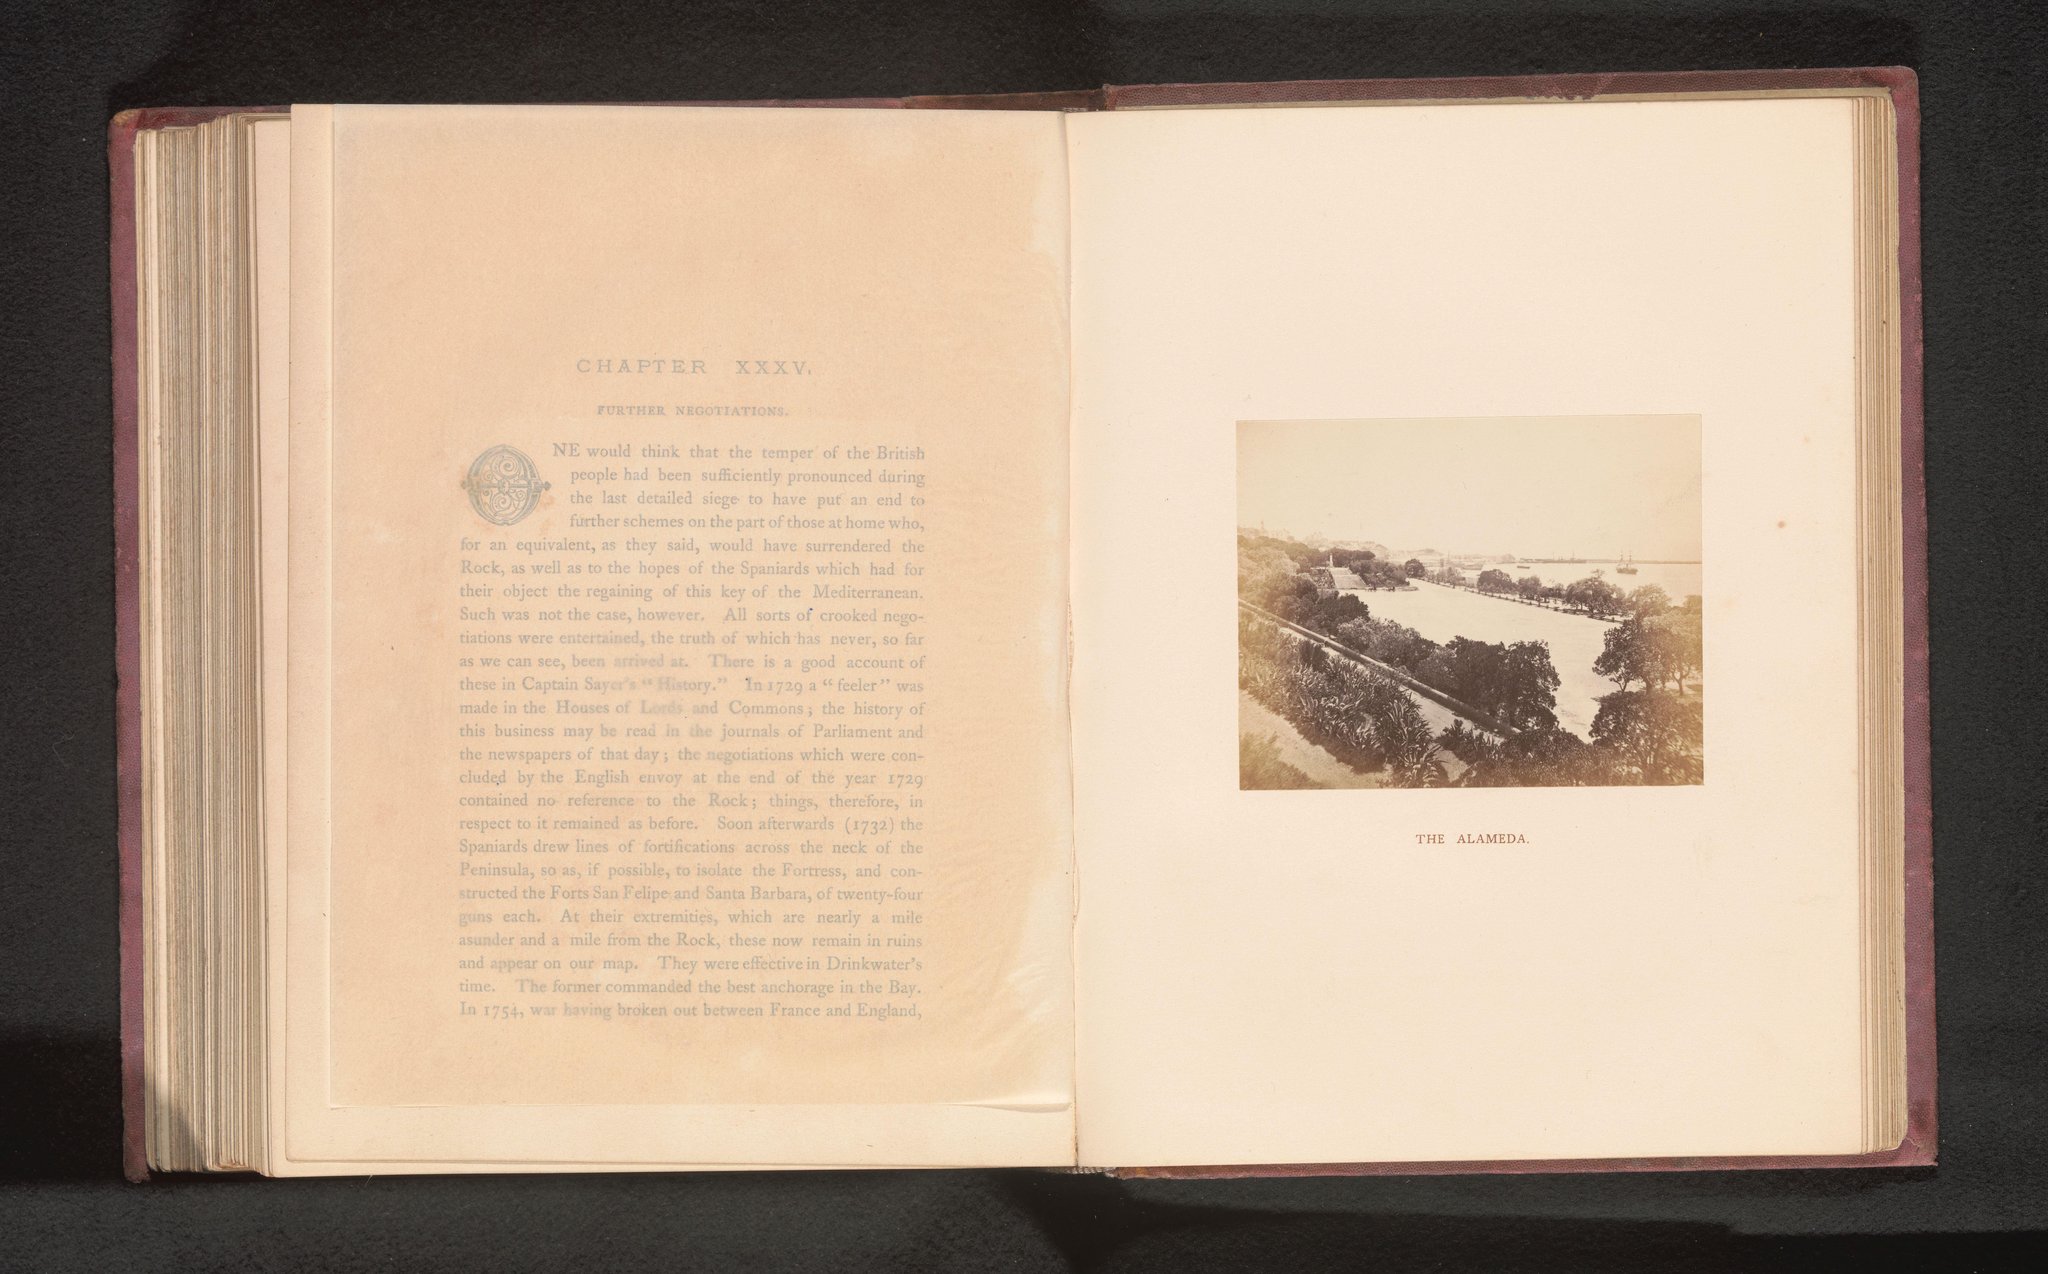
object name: page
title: The Alameda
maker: j.h. mann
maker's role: fotograaf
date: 1860-1870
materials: photographic support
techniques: albumen print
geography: gibraltar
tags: botanic garden, 'hortus botanicus'